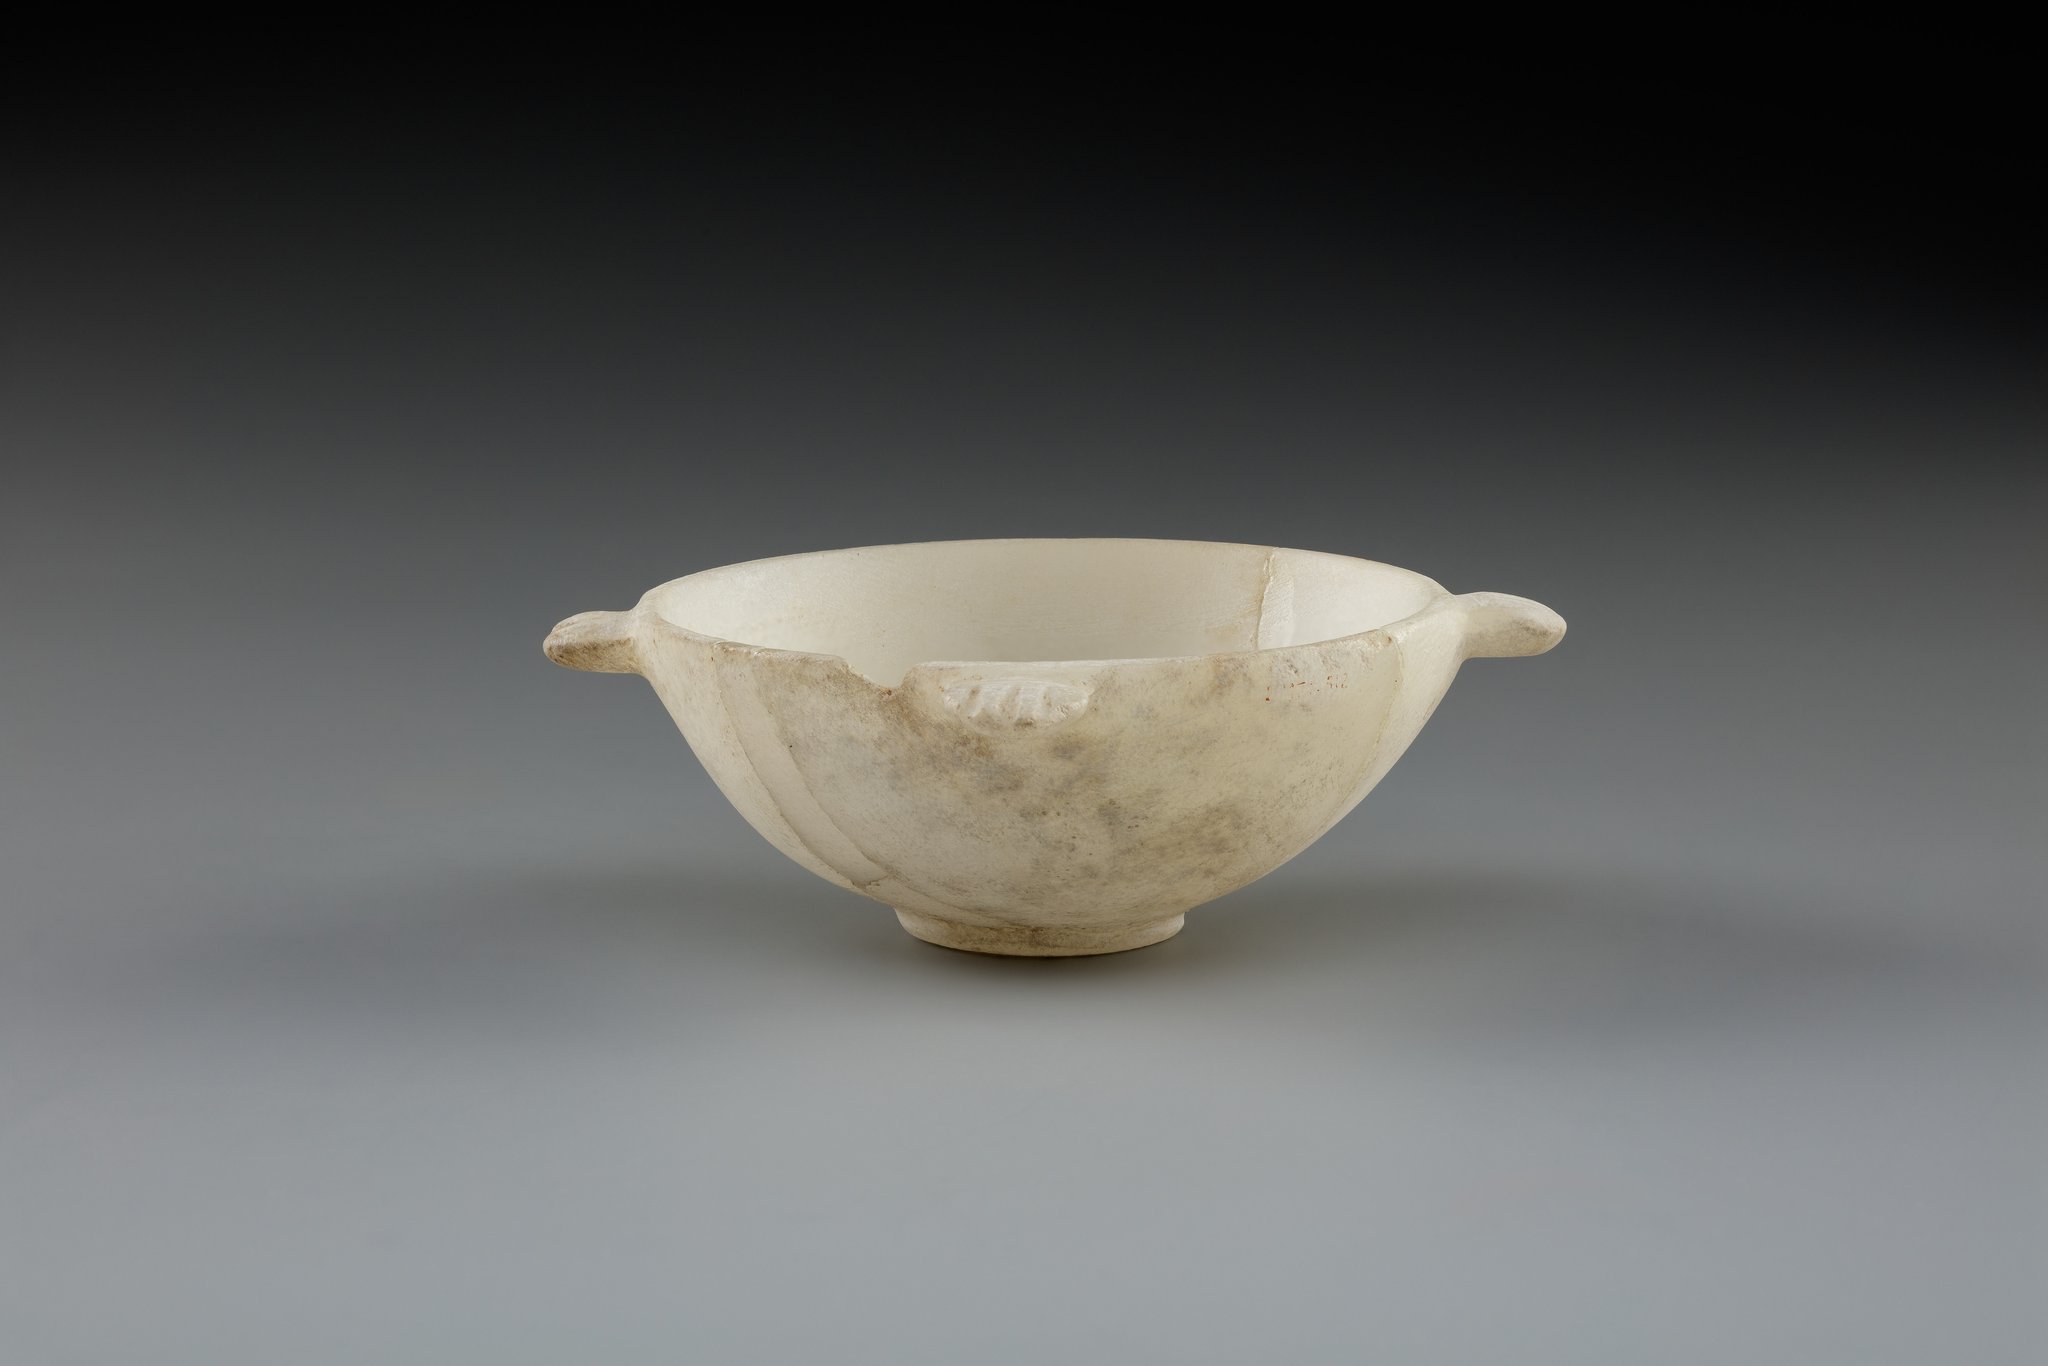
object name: bowl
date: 664-332 BCE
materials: stone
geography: egypt